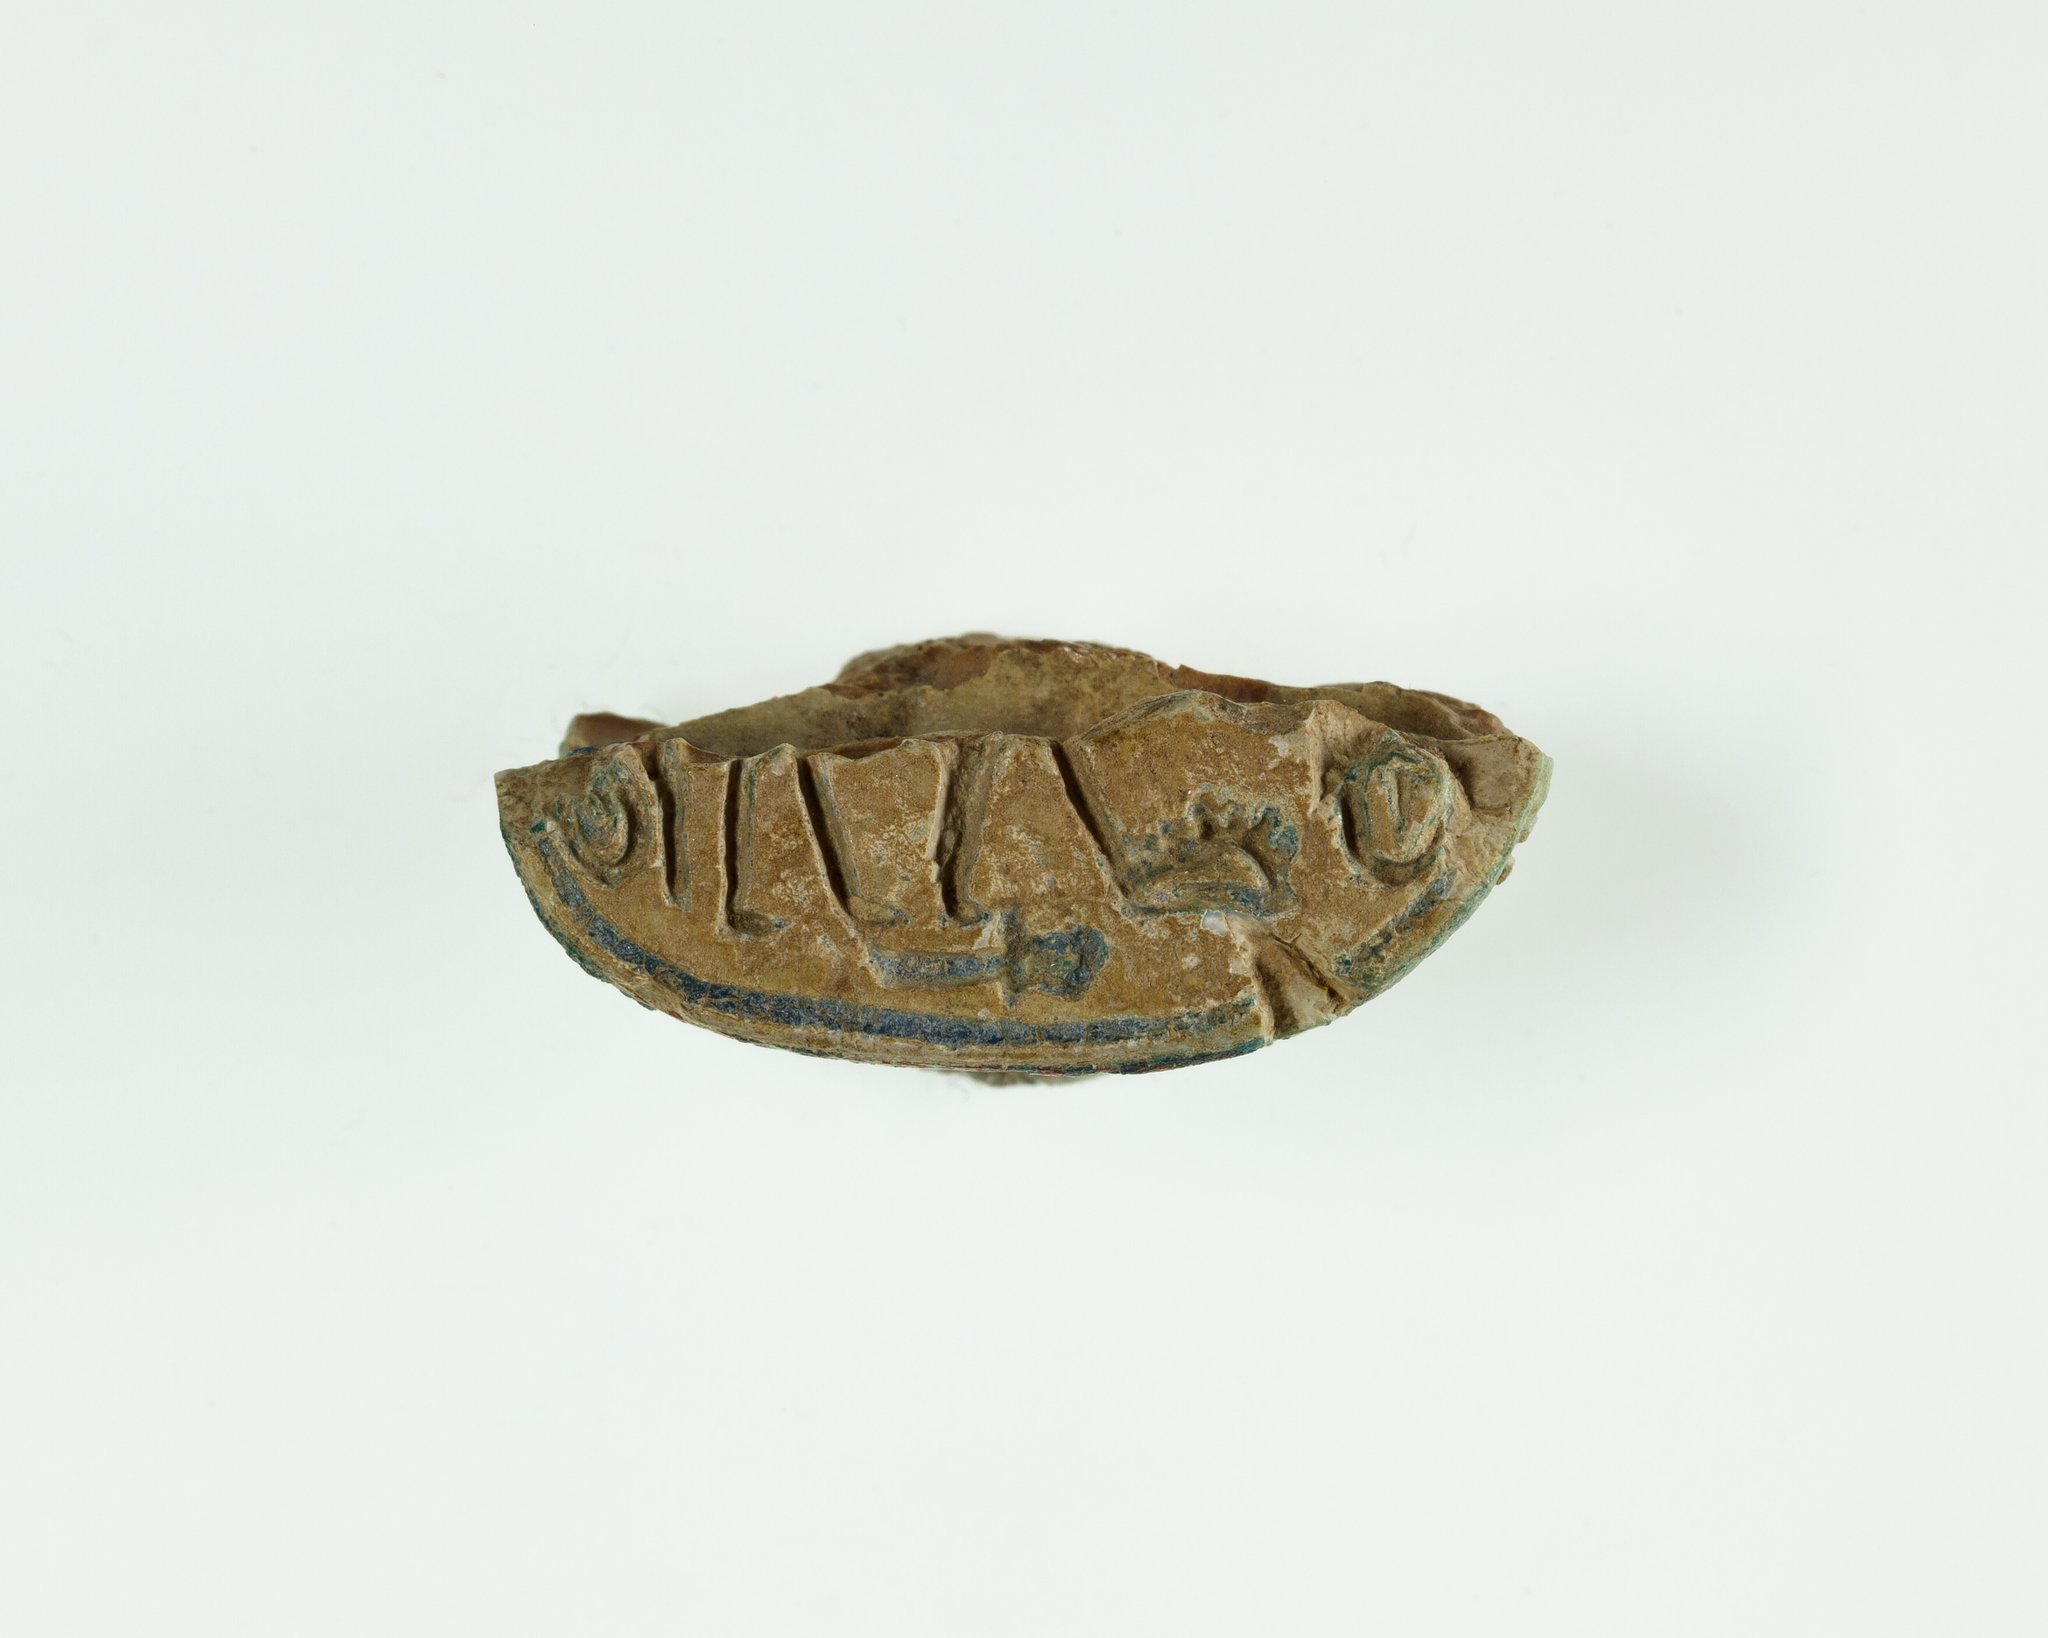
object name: scarab, hieroglyph, quadruped, ankh, nefer, kha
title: Fragment of a Scarab Inscribed with Hieroglyphs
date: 1850-1640 BCE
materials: stone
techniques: glazing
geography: egypt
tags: scarabs